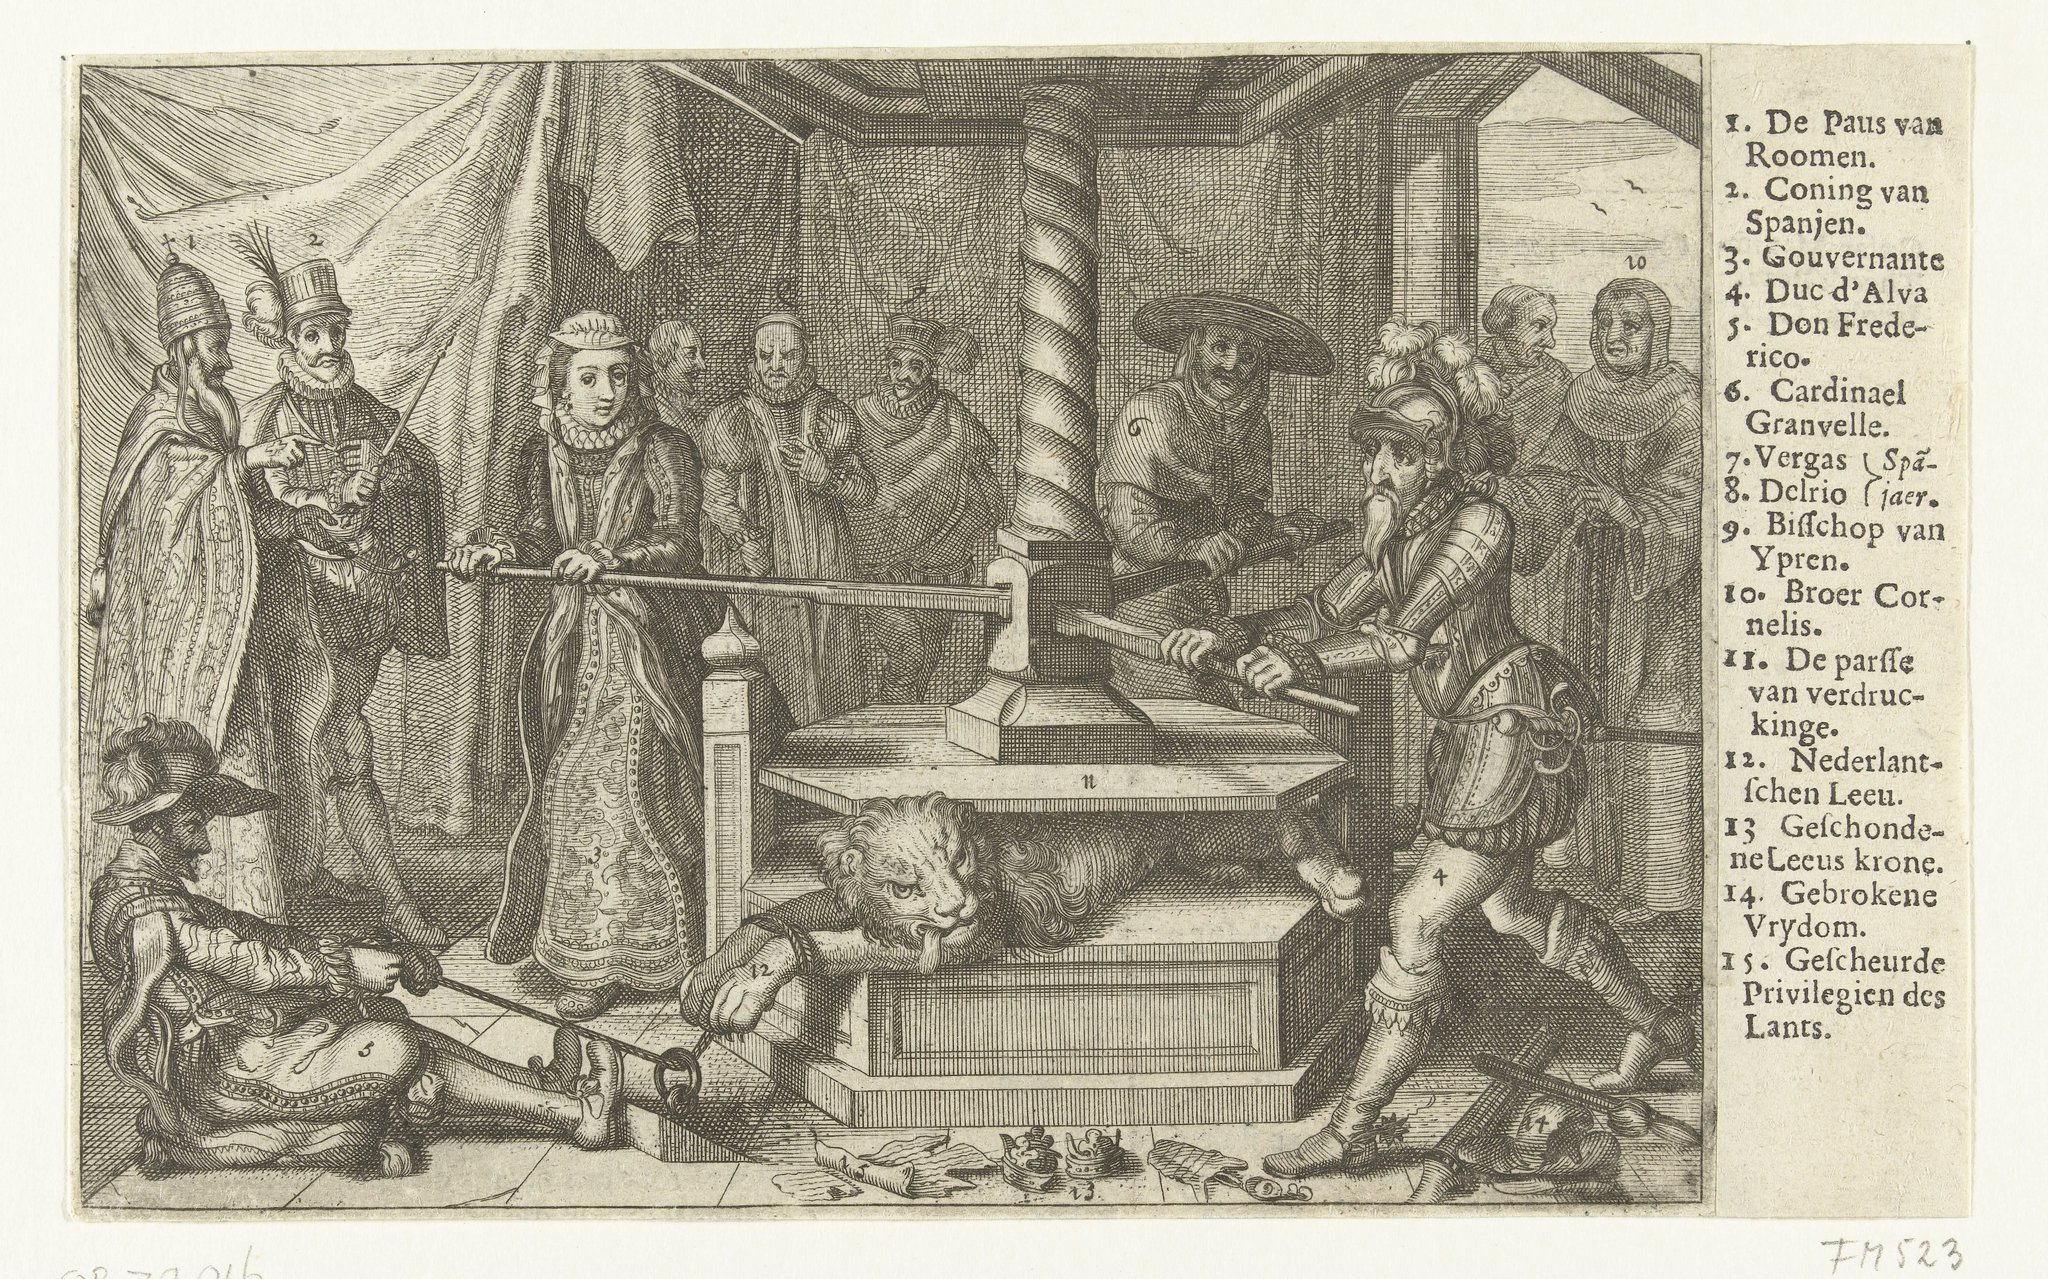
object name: print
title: De verdrukking van de Nederlanden onder Alva, ca. 1567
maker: pieter serwouters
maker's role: draughtsman, print maker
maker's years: 1586-1657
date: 1624-1626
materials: paper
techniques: engraving, letterpress printing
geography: northern netherlands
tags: philip ii of spain, rome, pius v, fernando álvarez de toledo (3rd duke of alba), antoine perrenot de granvelle, dordrecht, bruges, printing press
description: De Nederlandse Leeuw in een drukpers aangedraaid door Alva, Granvelle en Margaretha van Parma terwijl Don Frederik de leeuw vasthoudt. Onder de omstanders die toekijken bevinden zich: de paus, de koning van Spanje, Vargas en Del Rio en Broer Cornelis. Rechts de legenda 1-15 in het Nederlands. Bedrukt op de achterzijde met muziek.